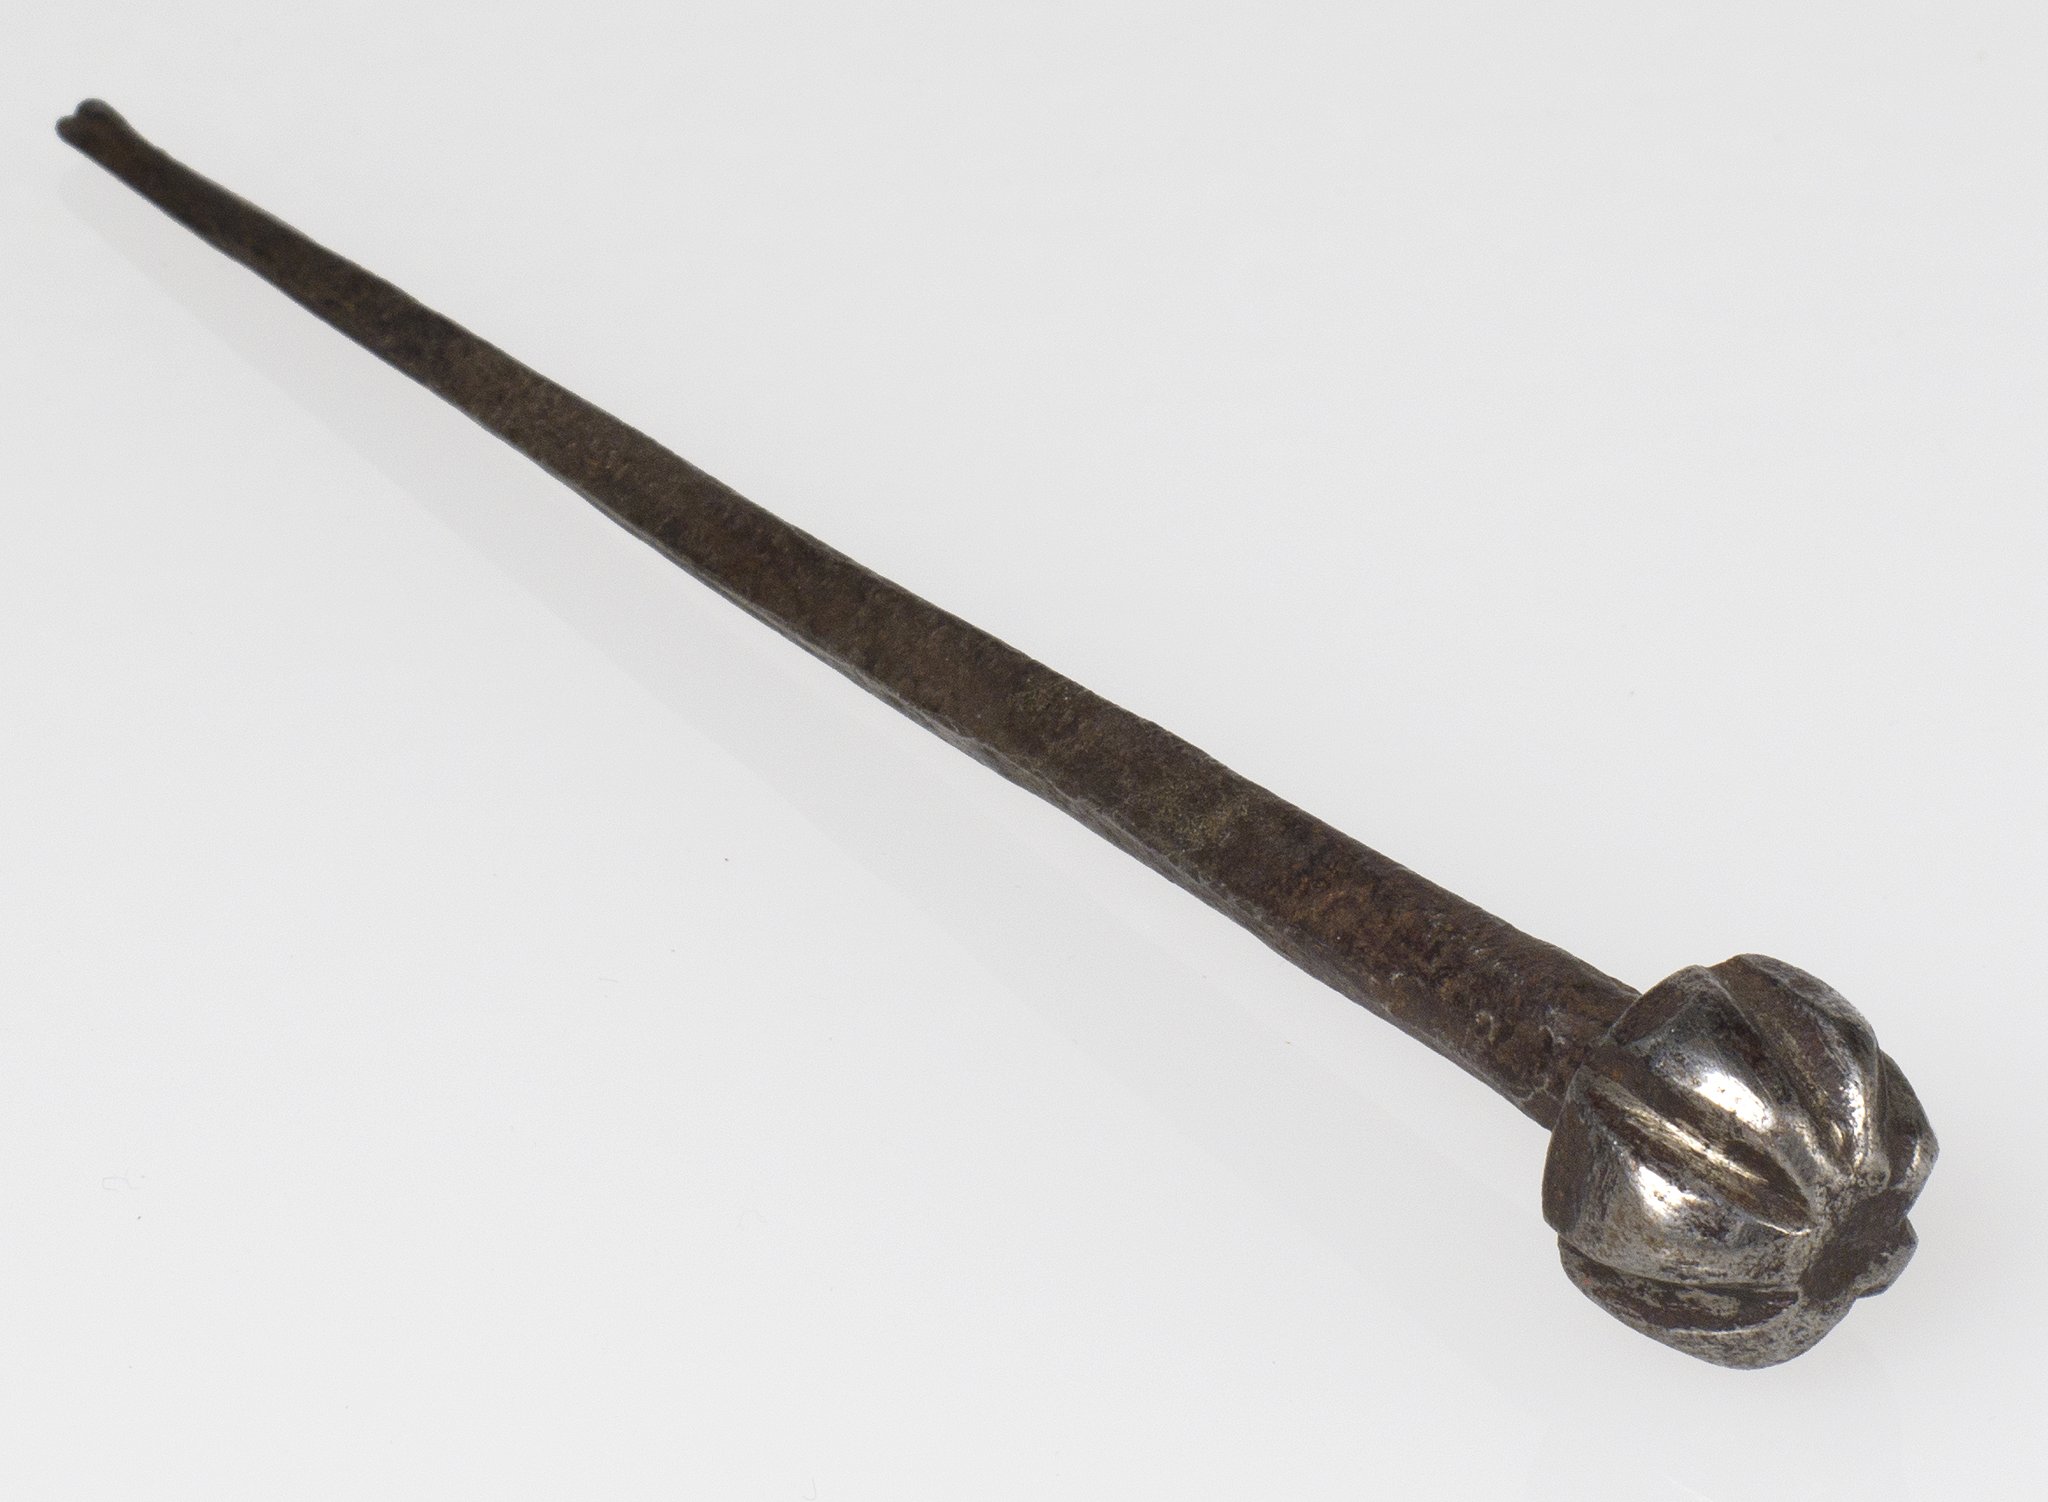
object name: nail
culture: european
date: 1401-1600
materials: iron